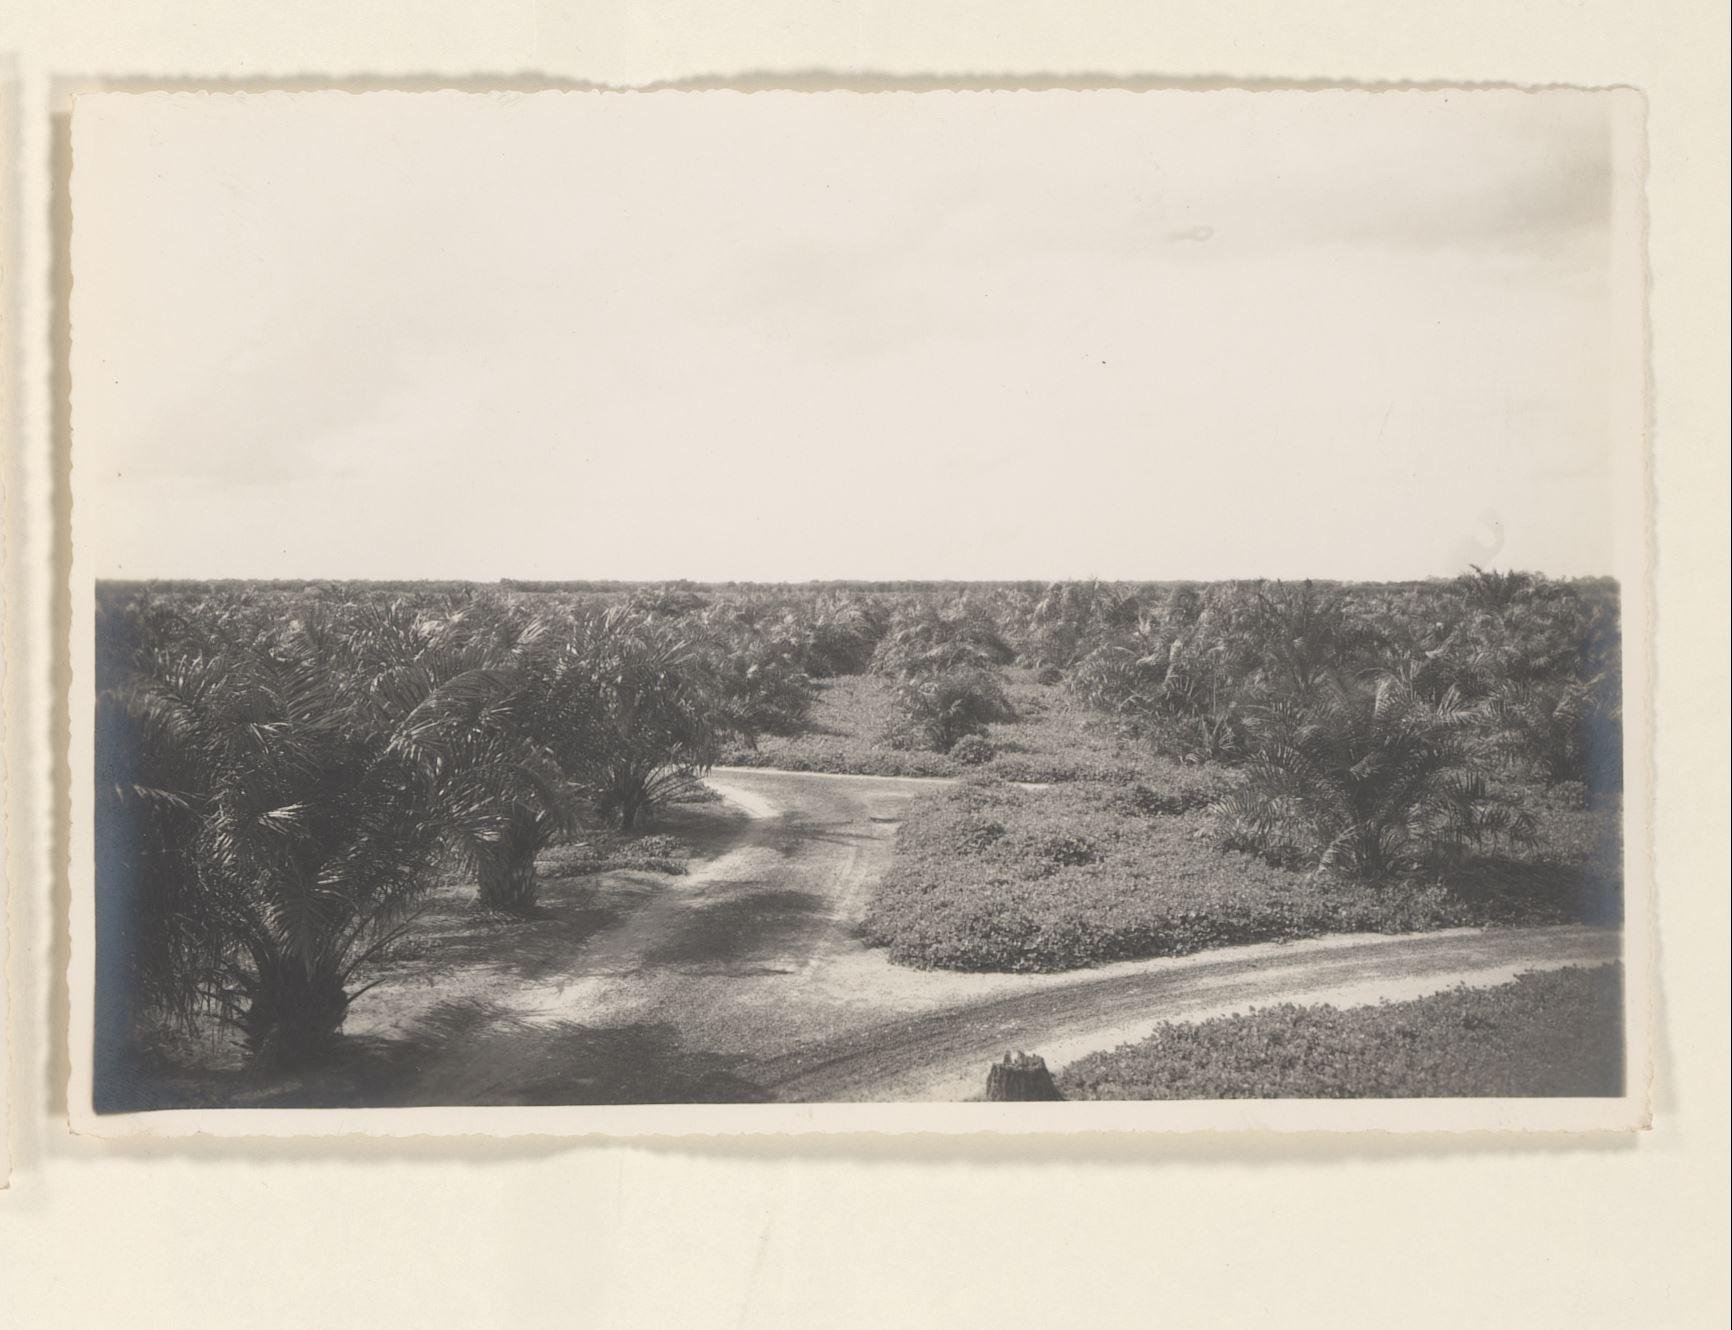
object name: photograph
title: Oliepalmenaanplant op Brussel, 1938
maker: Anonymous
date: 1907-1938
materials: photographic support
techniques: gelatin silver print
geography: sumatra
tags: plantation, (non-fruit) products of plants or trees: palm oil, sumatra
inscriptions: inscription: ‘Oliepalmen afd. II Brussel Juli '38’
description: Jonge oliepalmenaanplant op Brussel, juli 1938. Tweede afdruk, los in melinexhoesje, van een foto ingeplakt op albumblad 8. Onderdeel van het fotoalbum over de plantages Pernantian en Brussel van de Sumatra Caoutchouc Maatschappij op de Oostkust van Sumatra in de jaren 1935-1939.